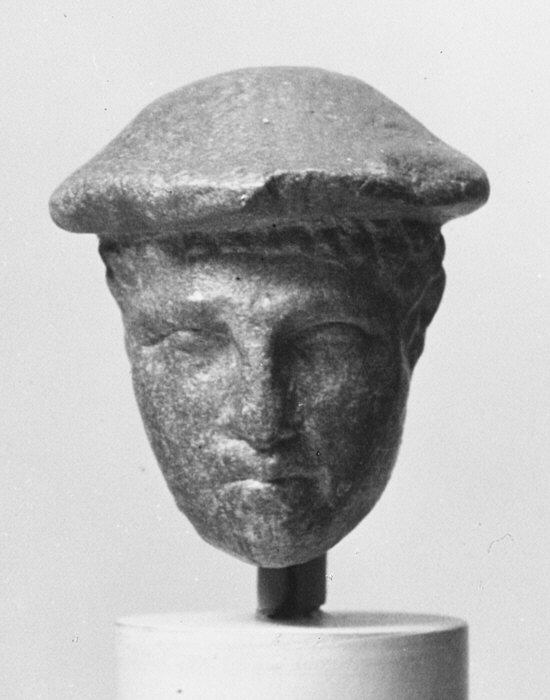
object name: head of a youth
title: Marble statuette head of a youth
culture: roman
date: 1-200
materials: marble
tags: heads,boys